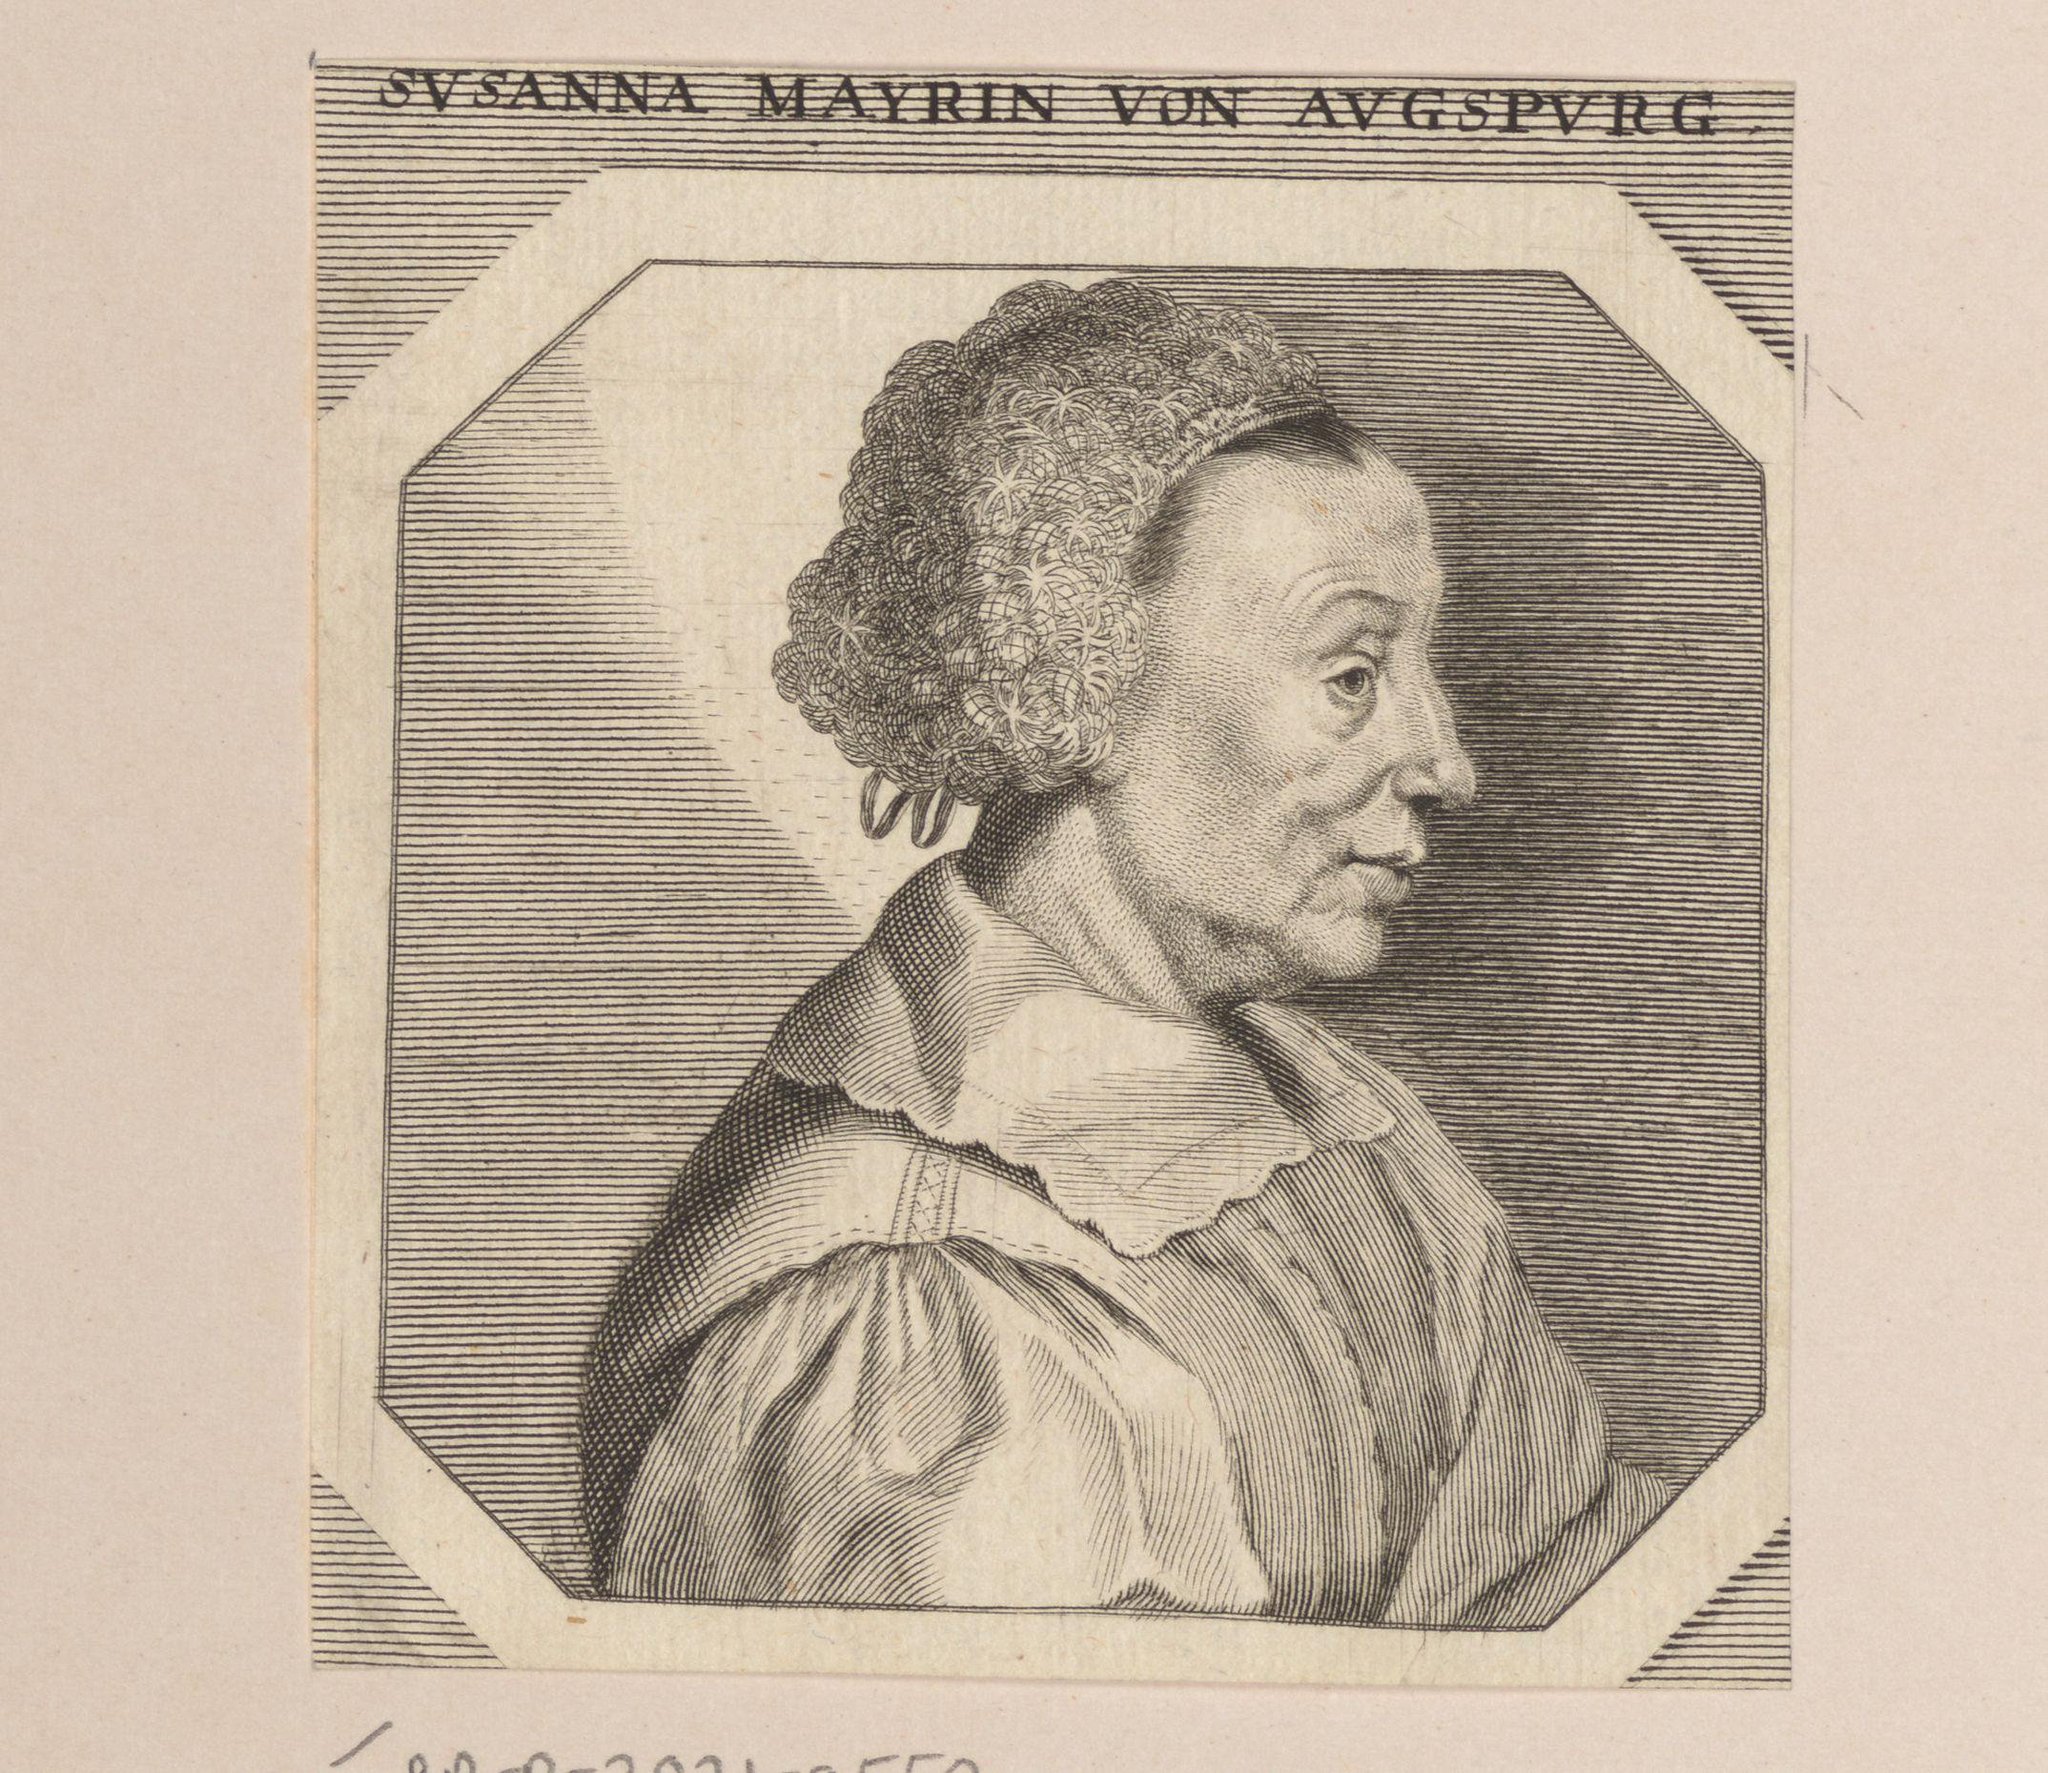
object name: print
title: Portret van Susanna Mayr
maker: georg andreas wolfgang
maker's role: goldsmith, print maker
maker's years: 1631-1716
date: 1675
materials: paper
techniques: engraving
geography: germany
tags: painter, susanna mayr, historical persons - bb - woman, portrait, self-portrait of painter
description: Prent waarschijnlijk uit: Sandrart, Joachim von. L'Academia Todesca della Architectura, Scultura e Pittura oder Teutsche Academie der Edlen Bau- Bild- und Mahlerey-Künste (...). Neurenberg: Jakob von Sandrart, 1675, dl. 2. Het portret is geknipt uit een grotere prent met nog vijf portretten.